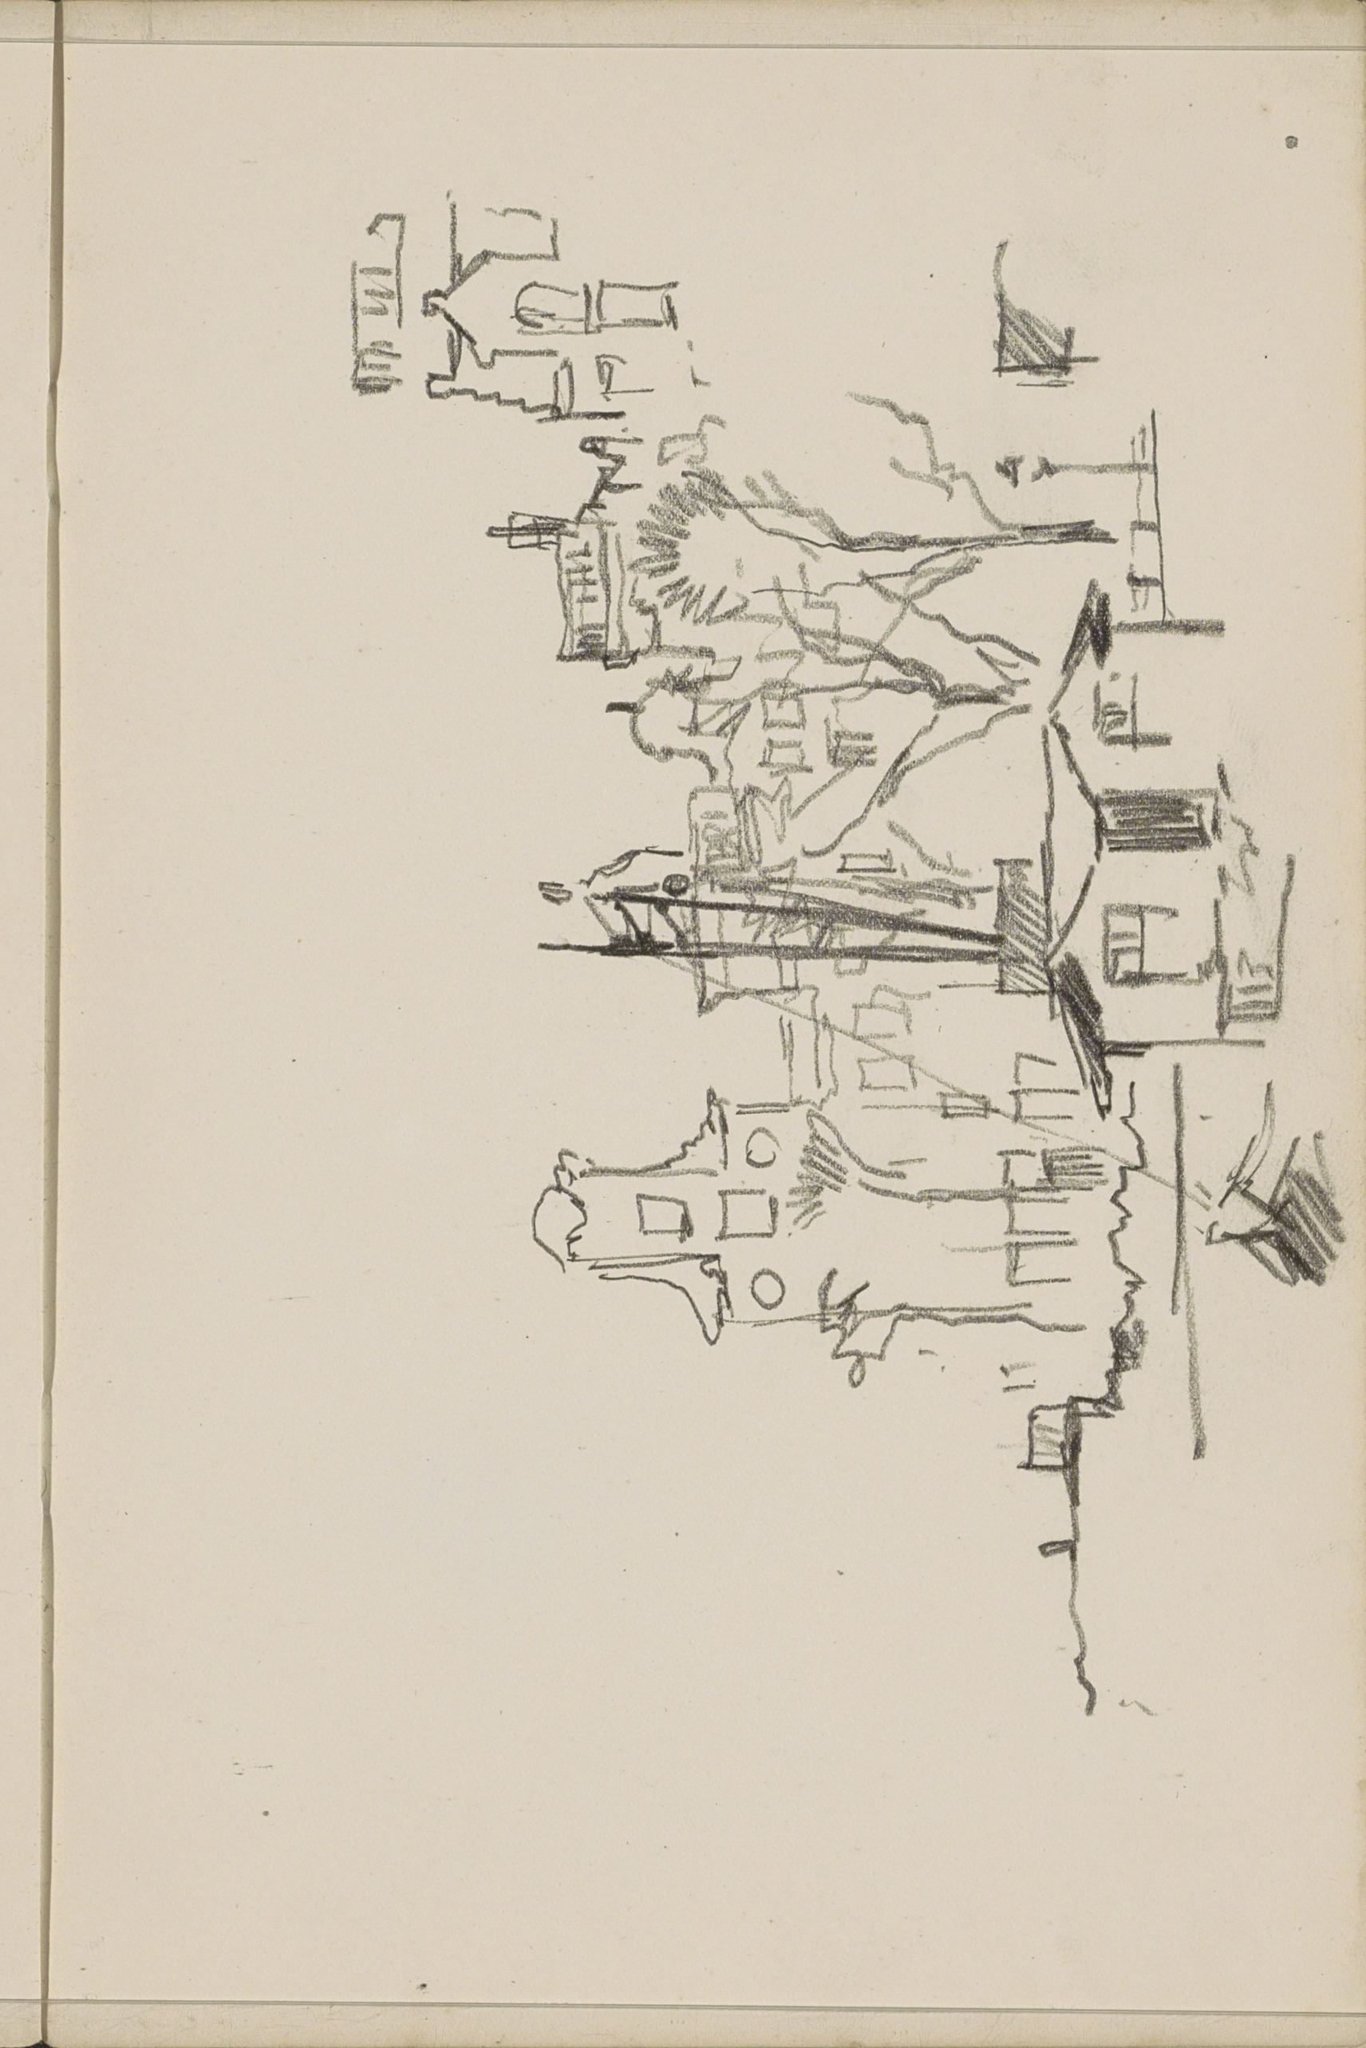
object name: sketchbook leaf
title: Rij huizen aan een kade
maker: cornelis vreedenburgh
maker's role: draughtsman, print maker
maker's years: 1880-1946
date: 1890-1946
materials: chalk, paper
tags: the usual house or row of houses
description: De huizen hebben verschillende soorten gevels. Blad 18 recto uit een schetsboek met 47 bladen.